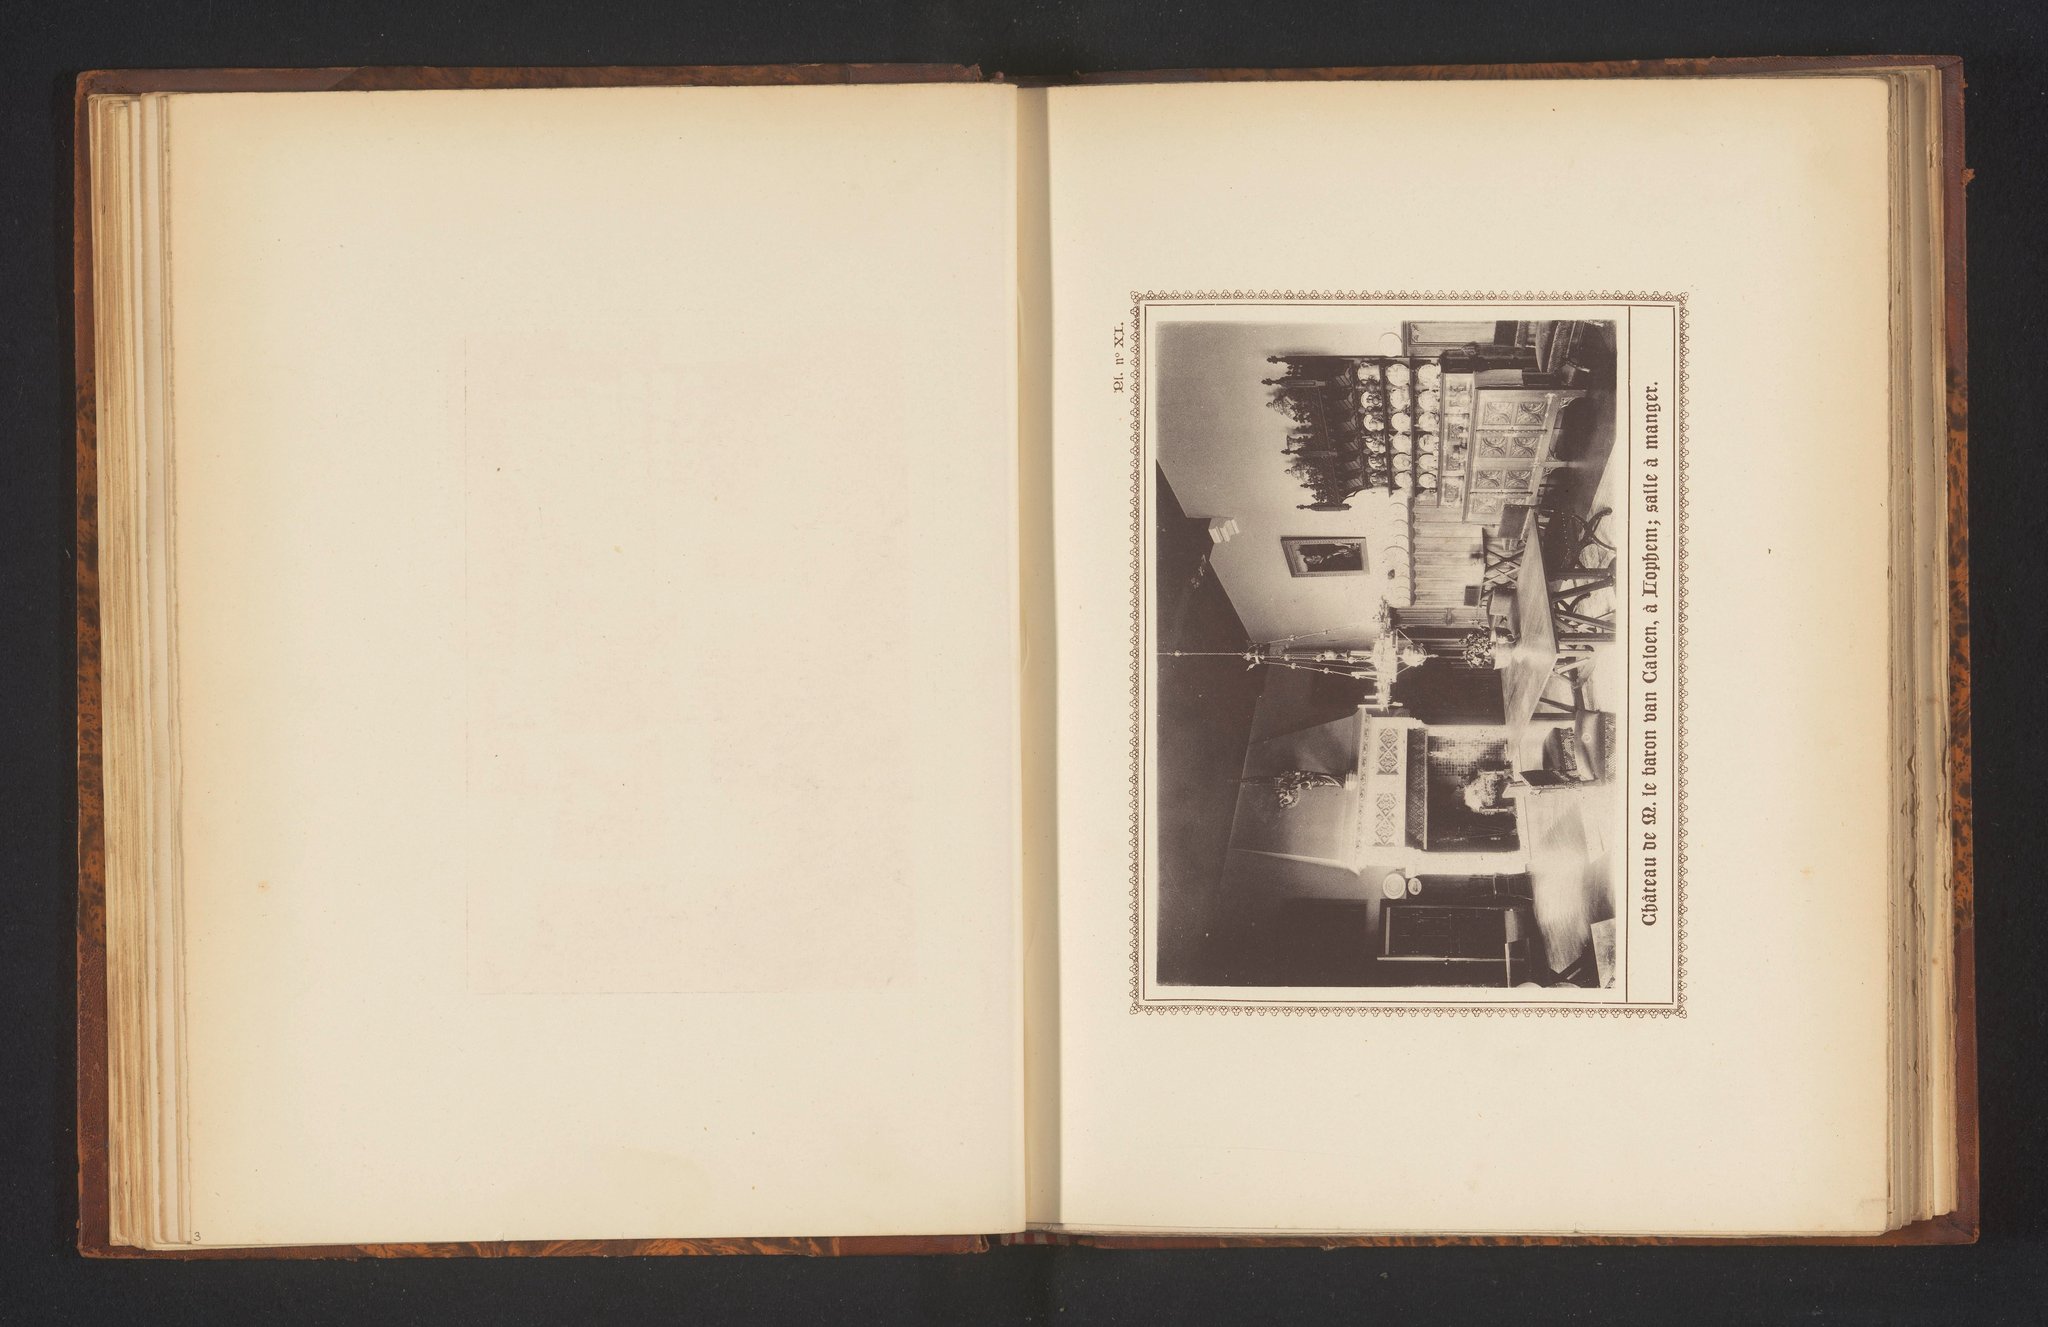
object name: photomechanical print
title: Gezicht op de eetzaal van het kasteel van Loppem in Zedelgem-Loppem, België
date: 1891-1896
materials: paper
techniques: photograph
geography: zedelgem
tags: castle, dining-room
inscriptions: number: ‘Pl. no XI.’